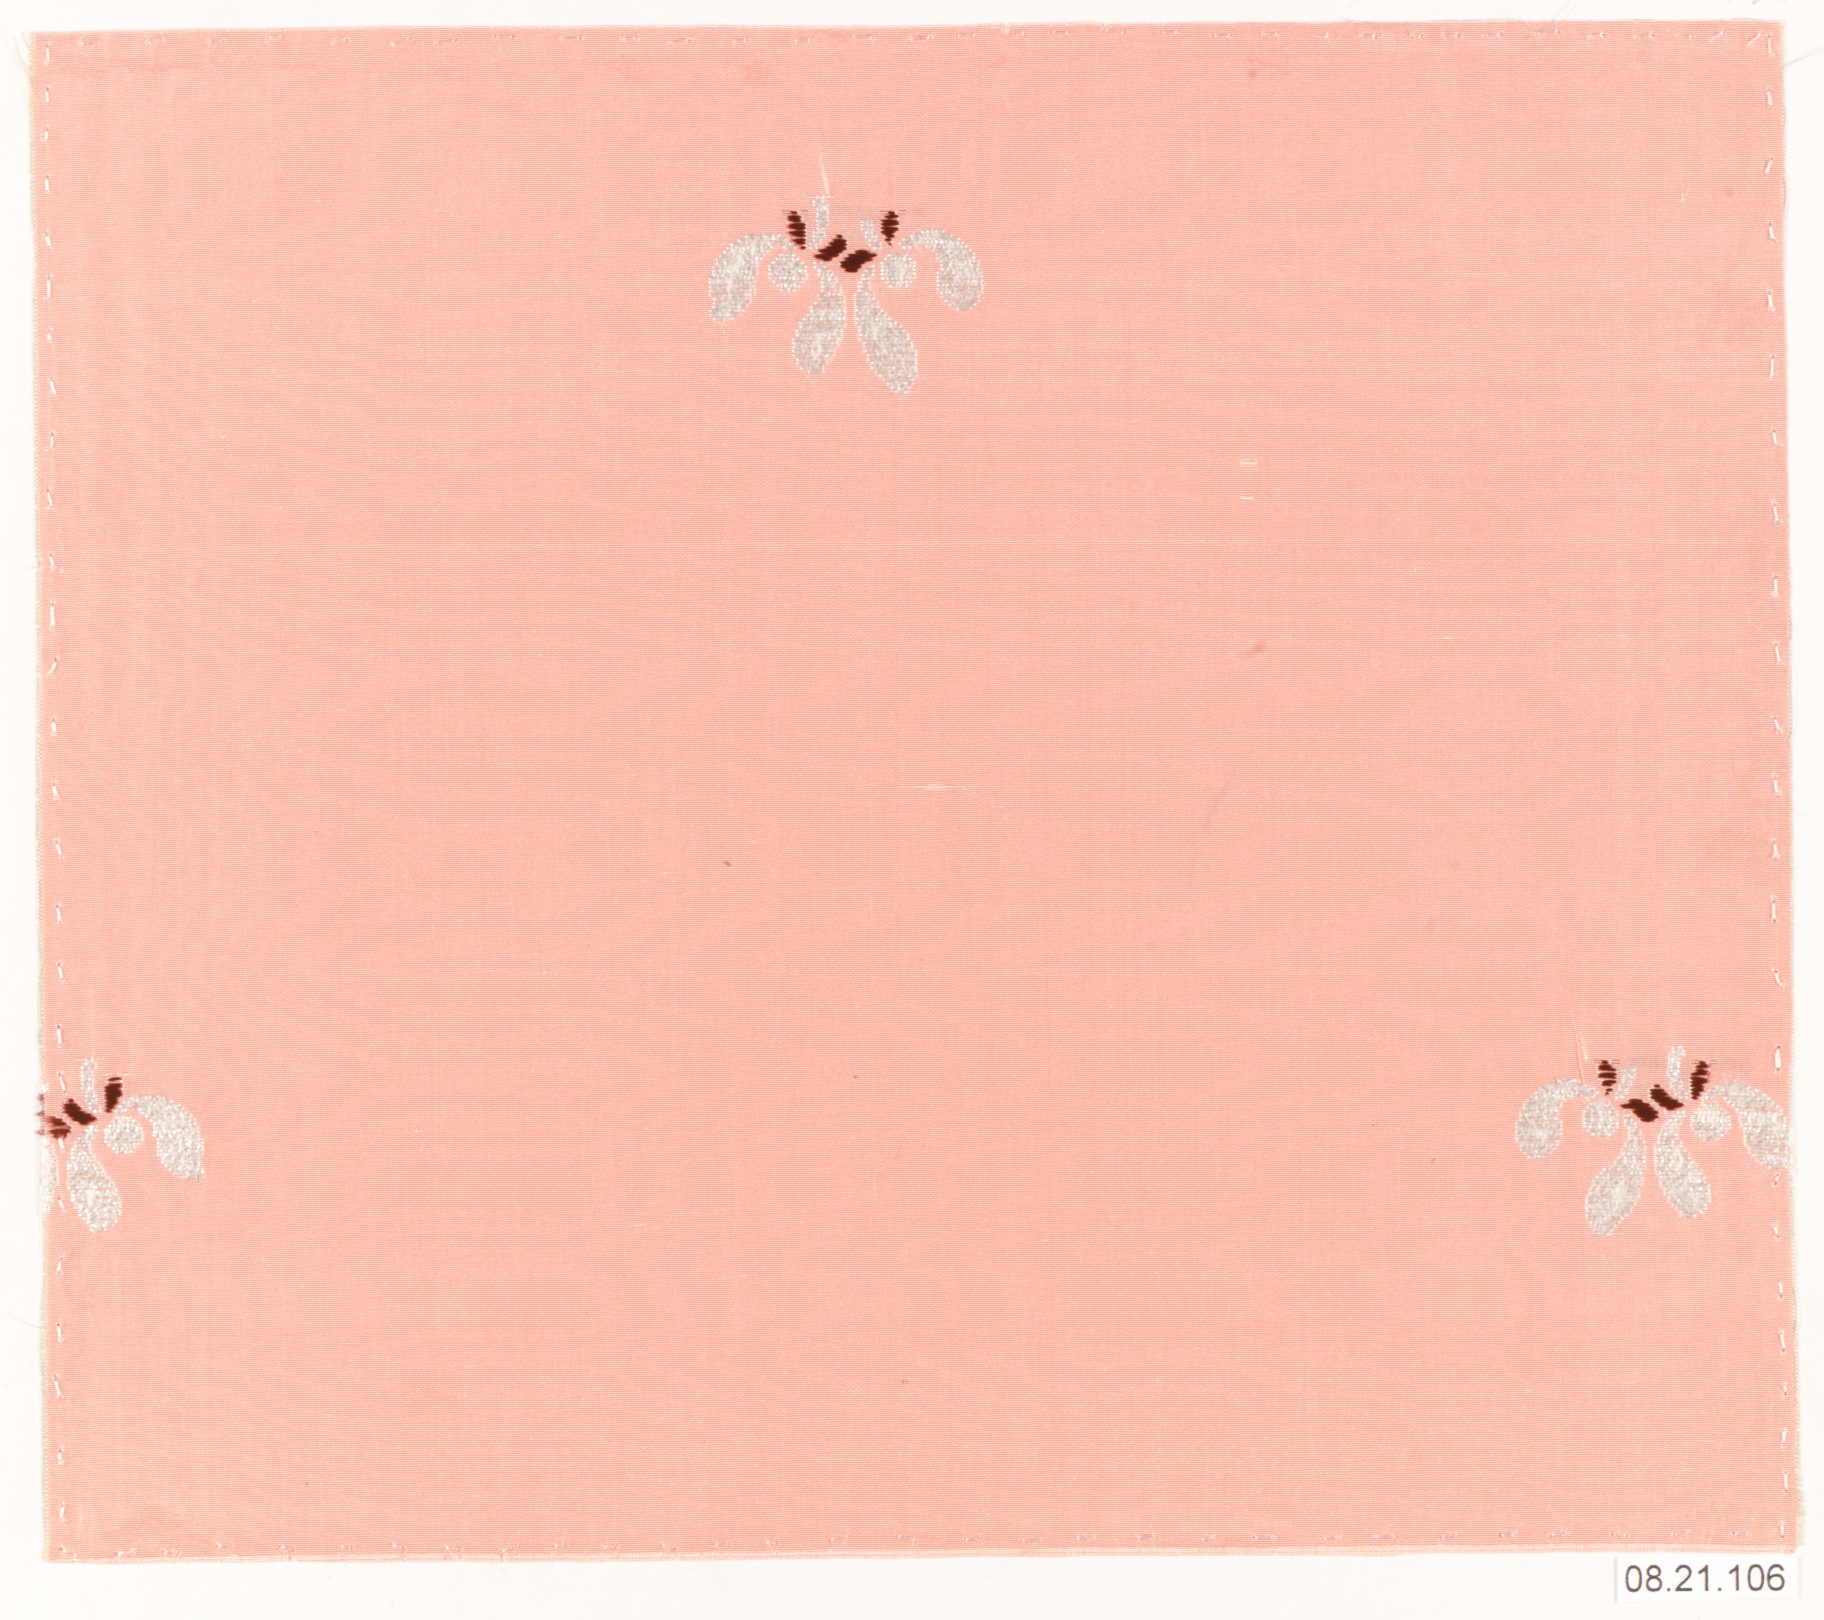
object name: textile sample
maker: Anonymous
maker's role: designer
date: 1900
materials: silk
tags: flowers